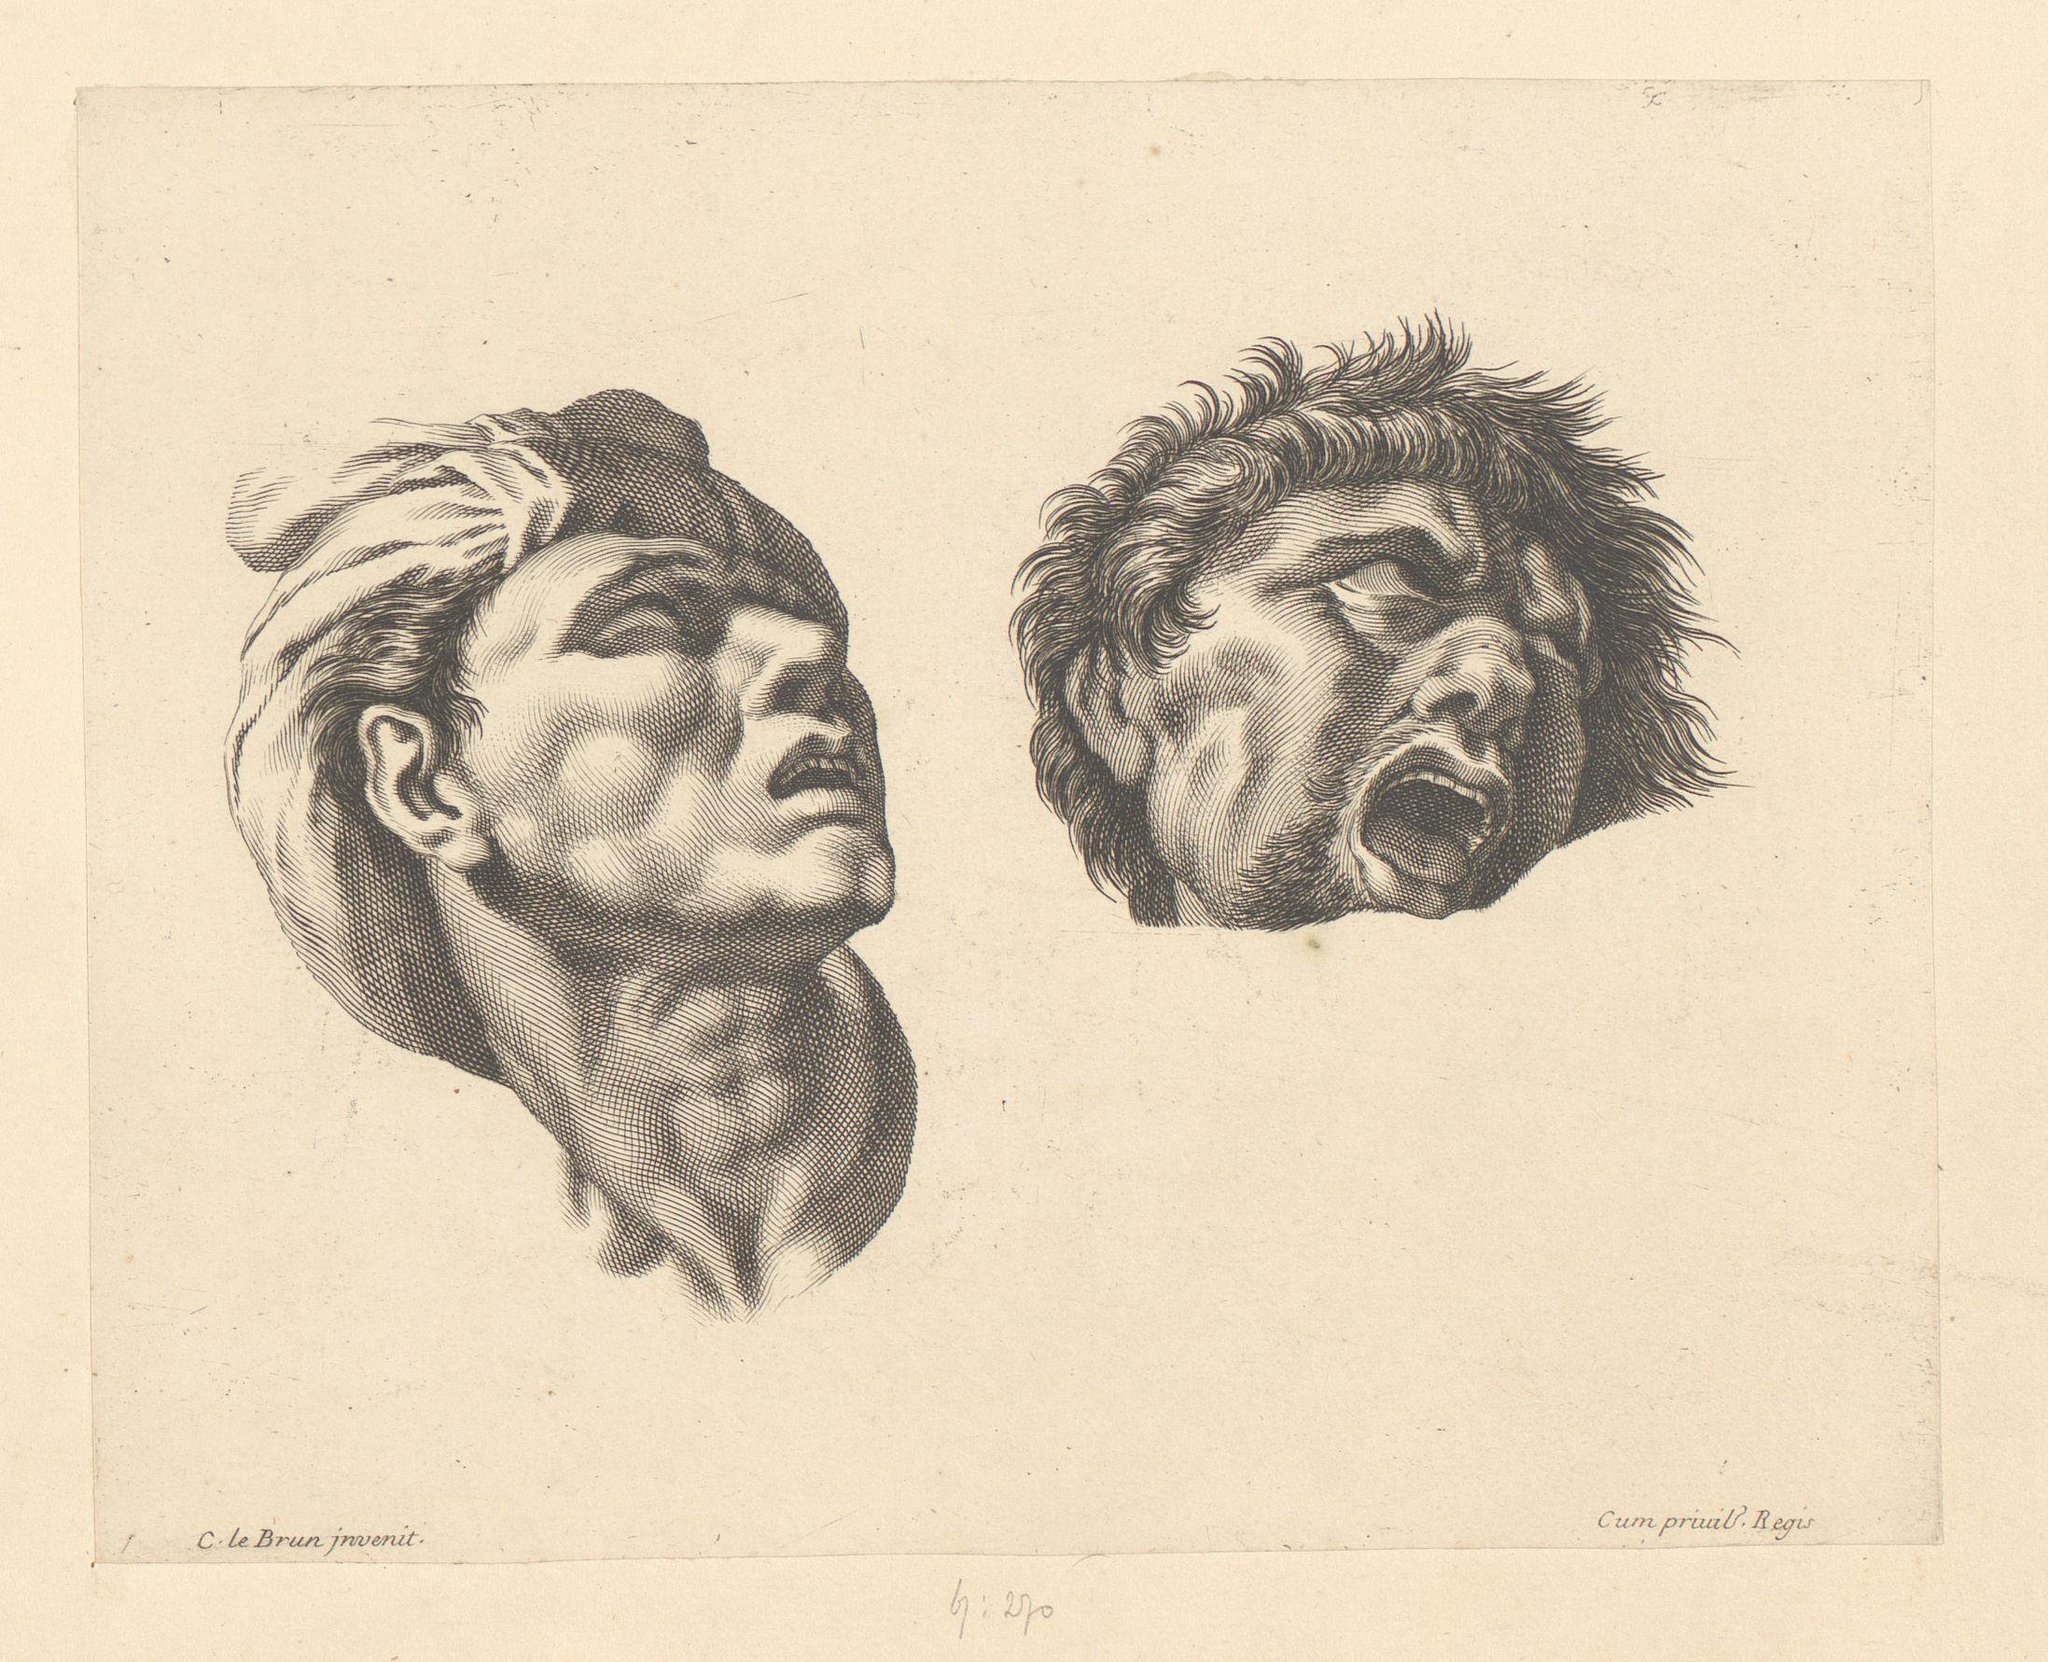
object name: album leaf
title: Portretboek voor beginners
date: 1700-1725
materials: paper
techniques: etching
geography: paris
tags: face, morphology of facial expression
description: Deze prent maakt deel uit van de serie 'Livre de portraiture', die weer onderdeel is van de grotere reeks 'Oeuvre de Charles le Brun'.